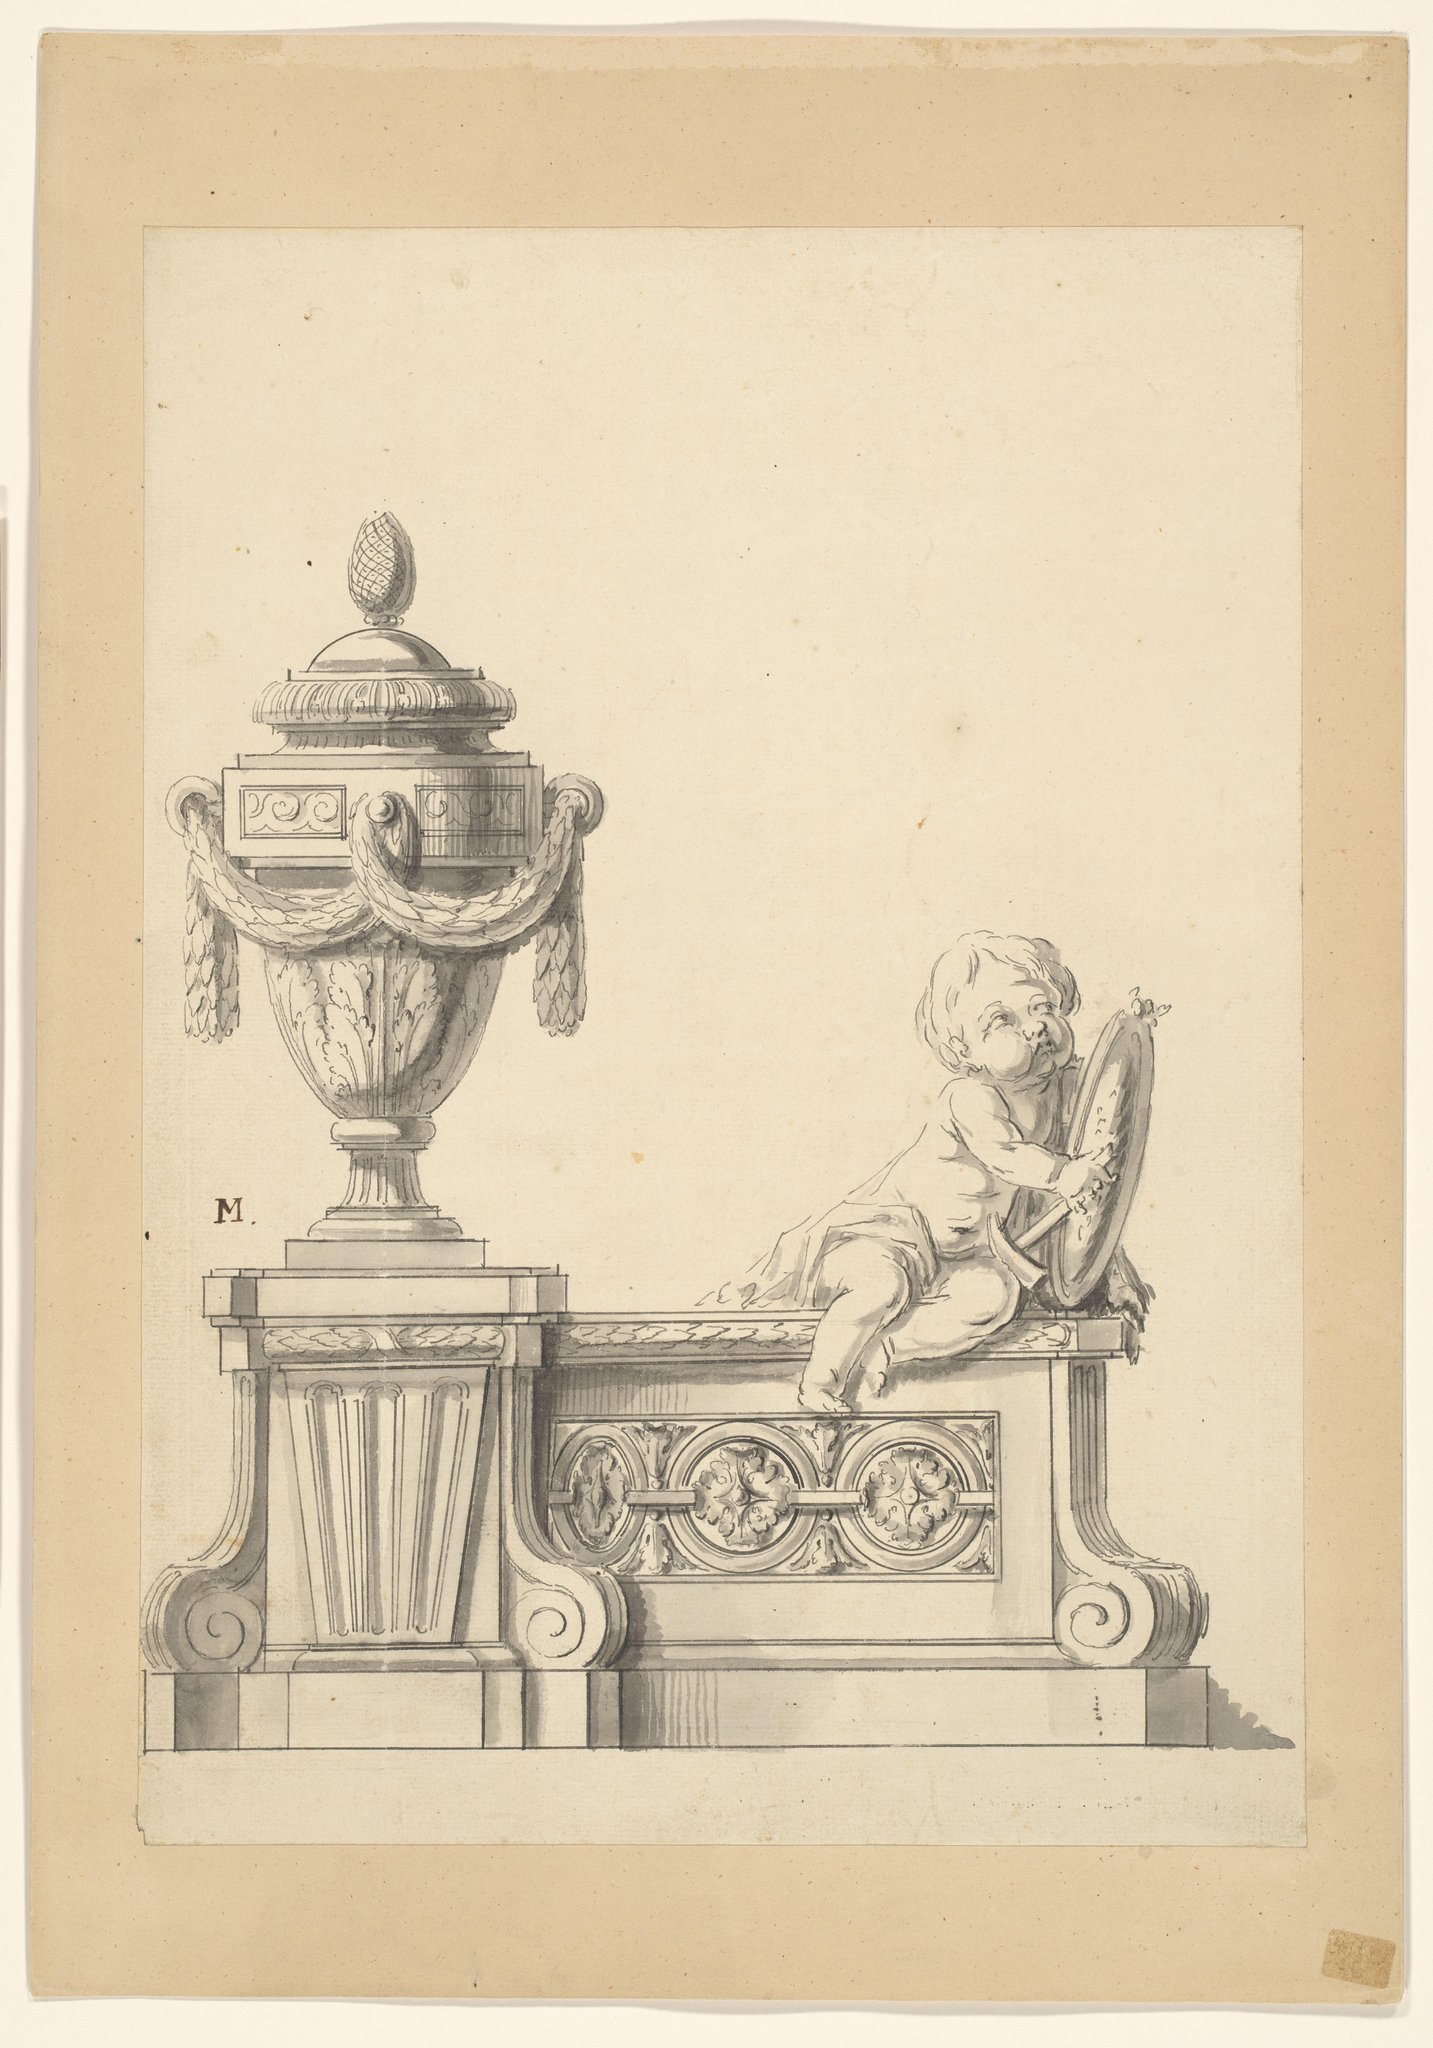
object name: drawing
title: Ontwerp voor een chenet met een zittend jongetje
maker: jean louis prieur (ii)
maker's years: 1732-1795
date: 1760-1770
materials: ink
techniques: brush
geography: paris